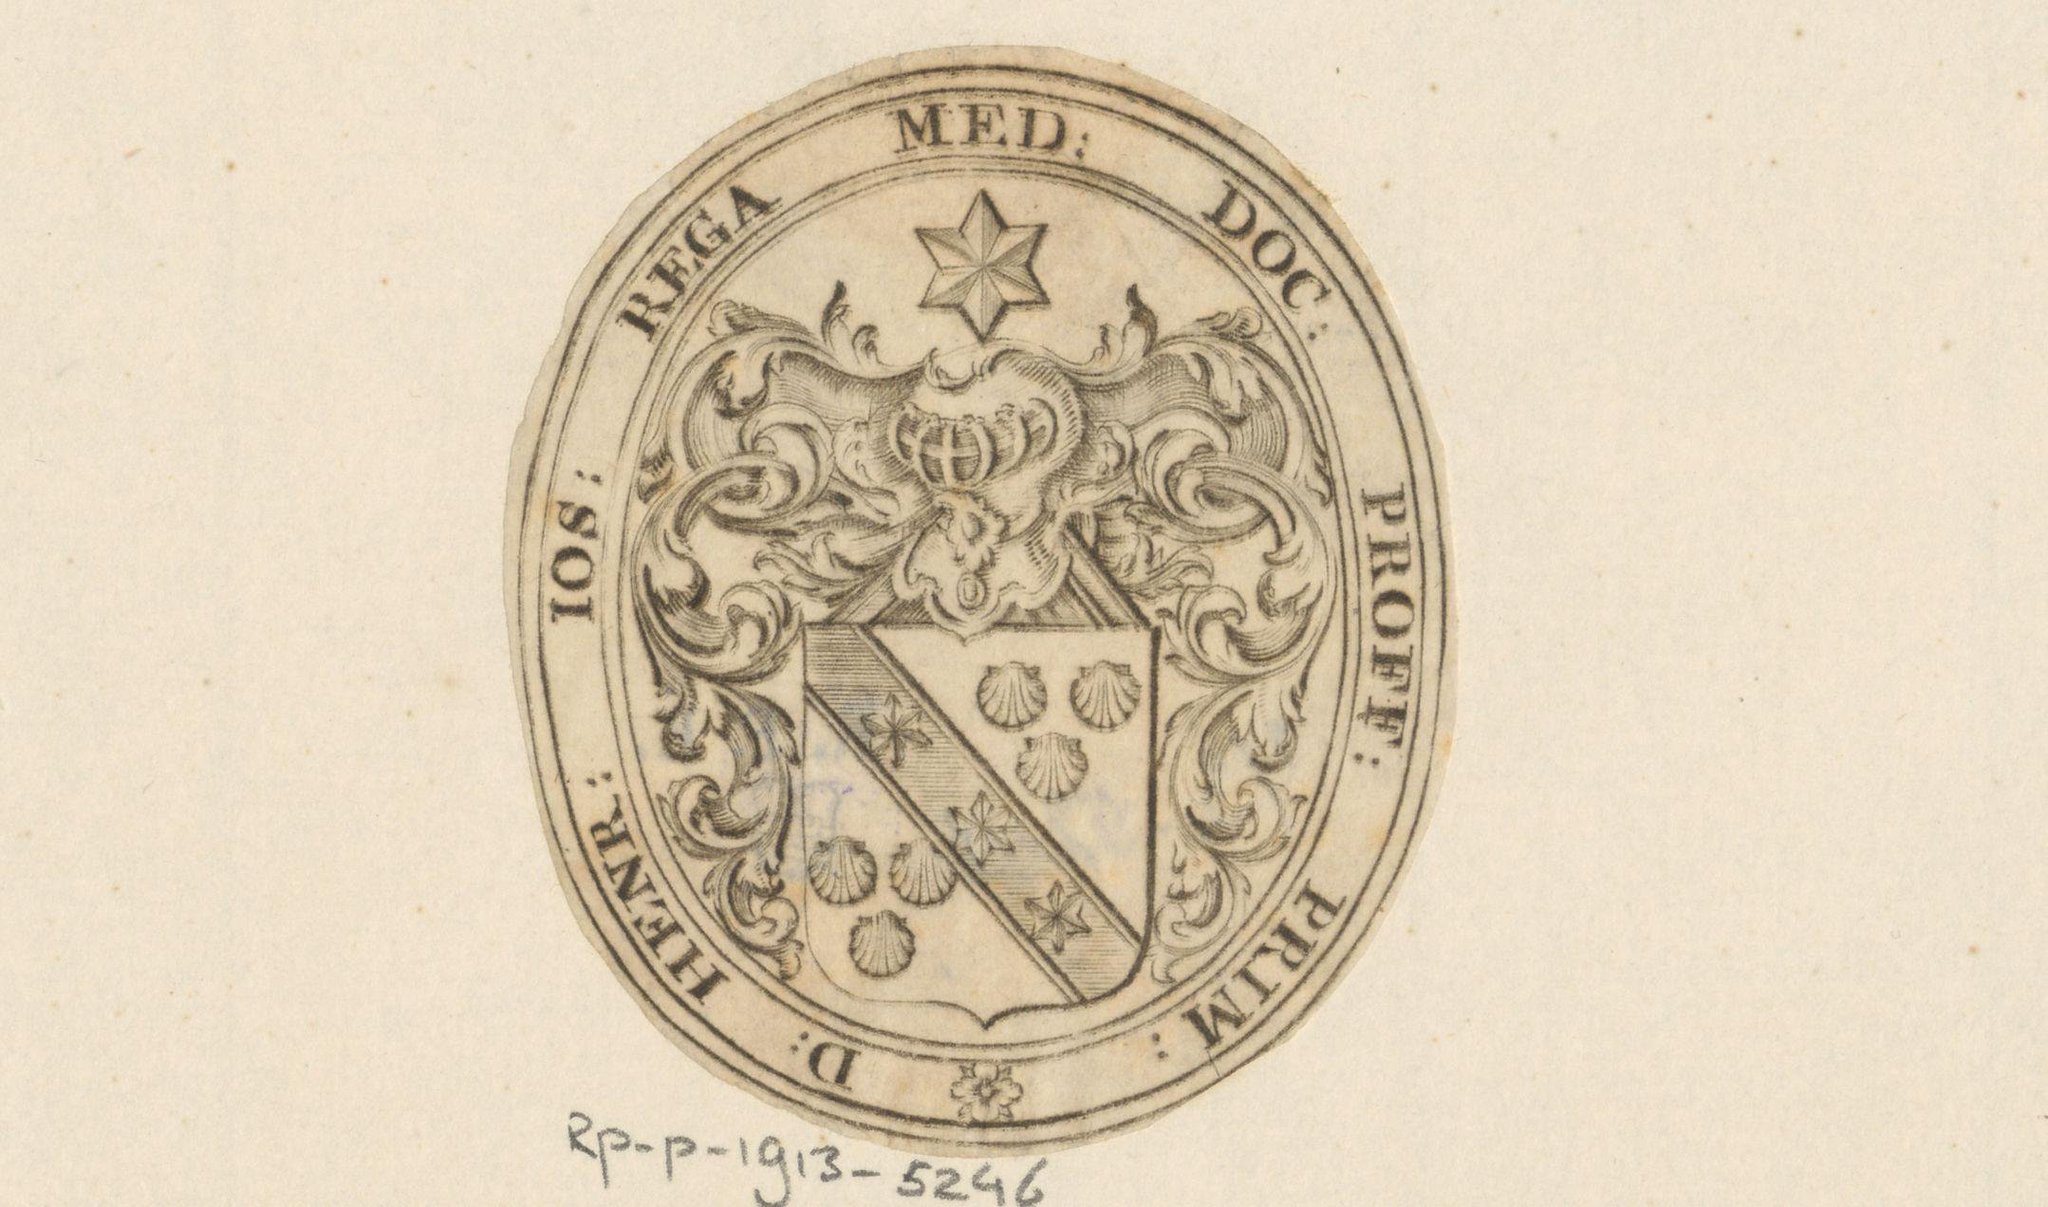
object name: bookplate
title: Ex libris van D. Henr. Ios. Rega Med. Doc. Proff. Prim.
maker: Anonymous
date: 1700-1799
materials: paper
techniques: engraving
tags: armorial bearing, heraldry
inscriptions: collector's mark: Lugt 2233, collector's mark: Lugt 2760